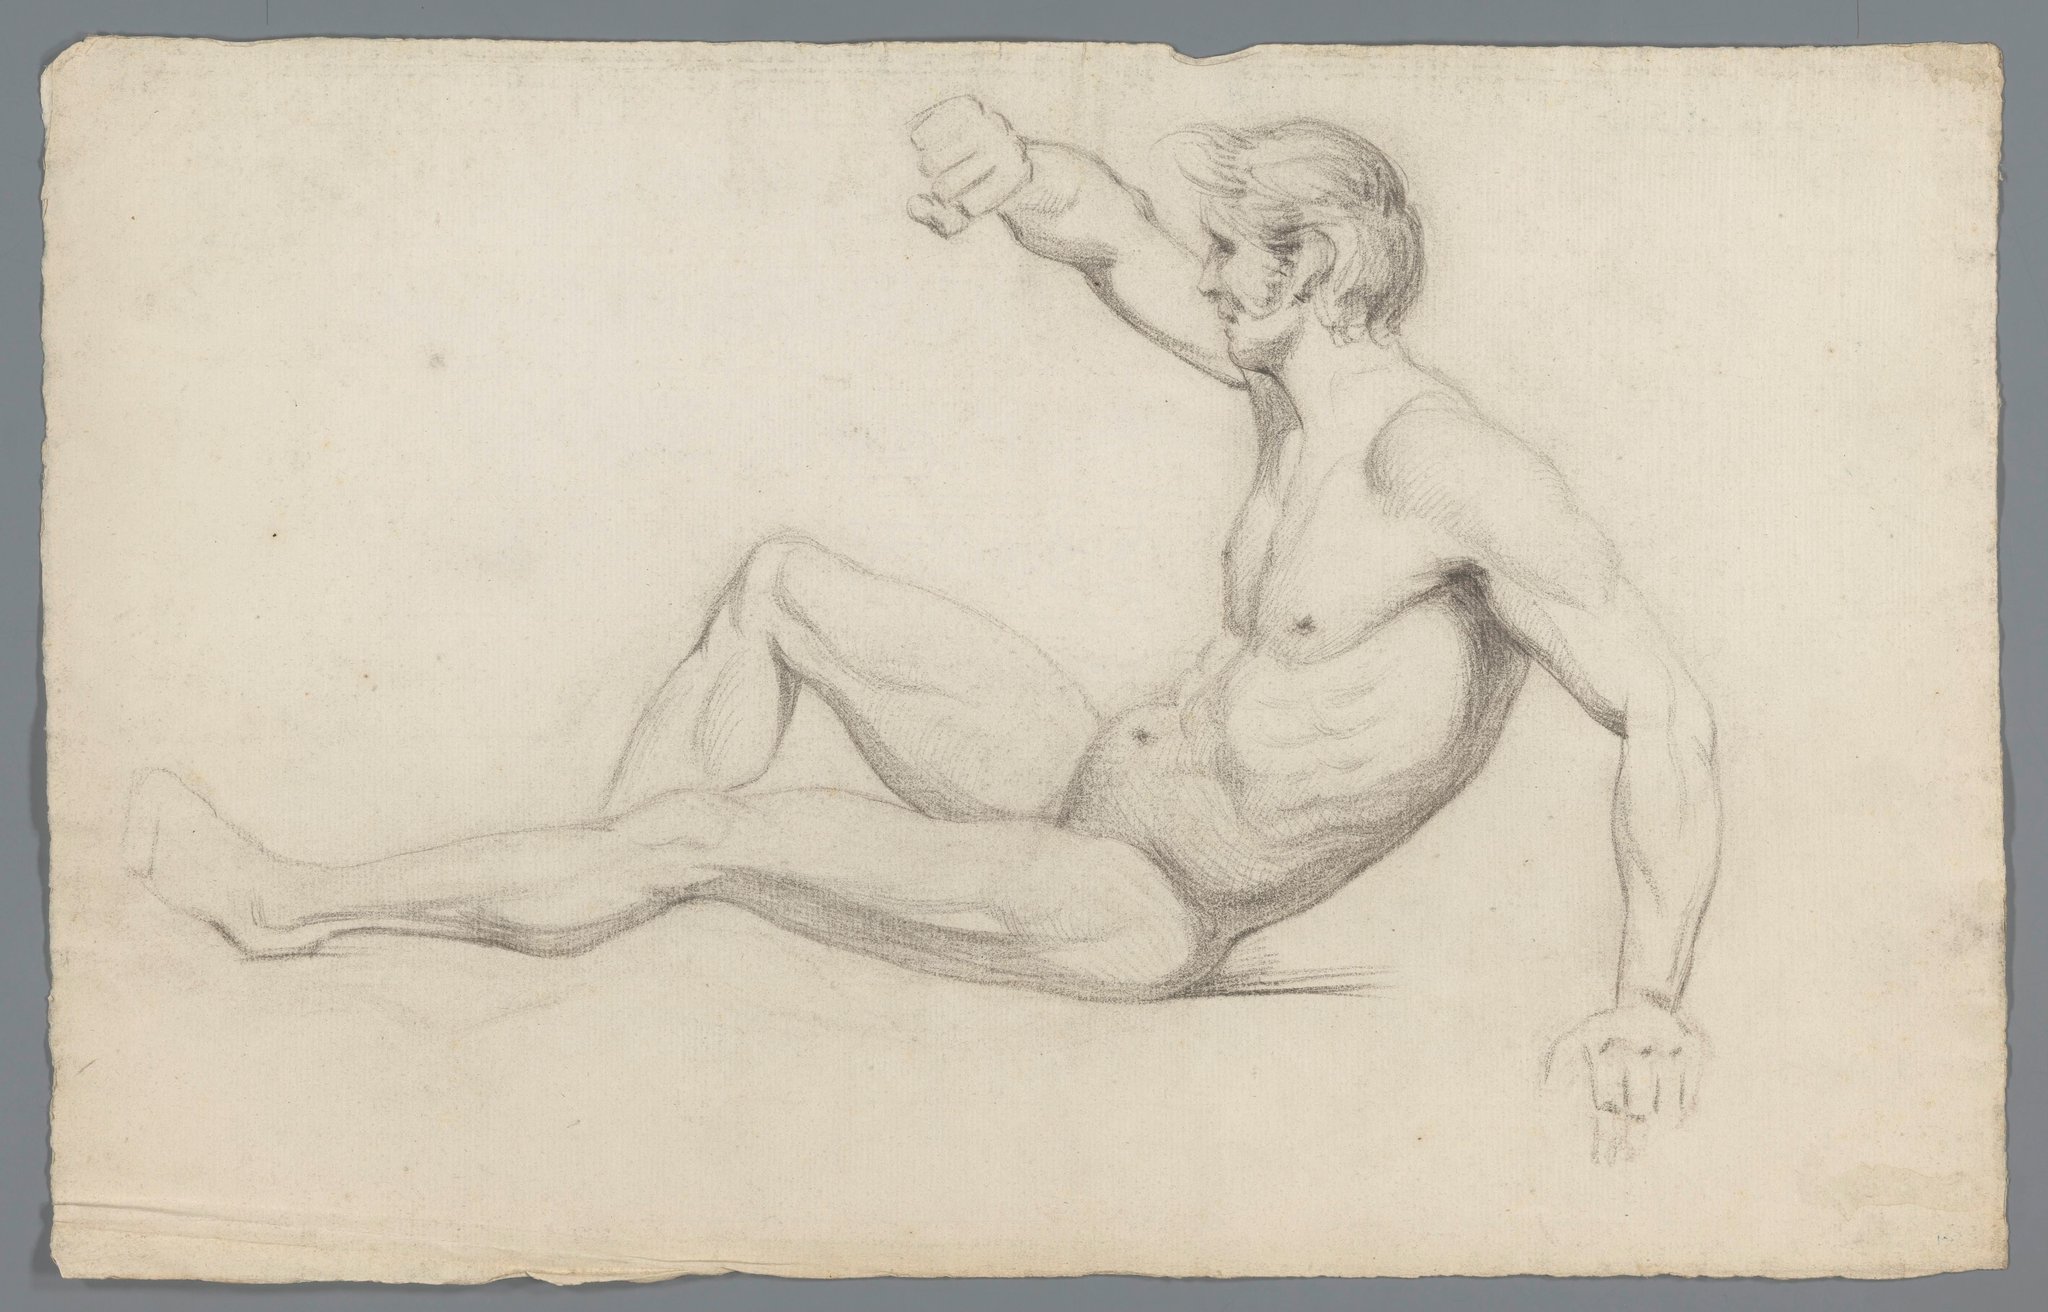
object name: drawing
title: Zittend mannelijk naakt, met opgeheven arm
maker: gerard allebé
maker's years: 1849-1879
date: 1818-1900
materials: chalk, paper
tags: the (nude) human figure; 'corpo humano' (ripa)